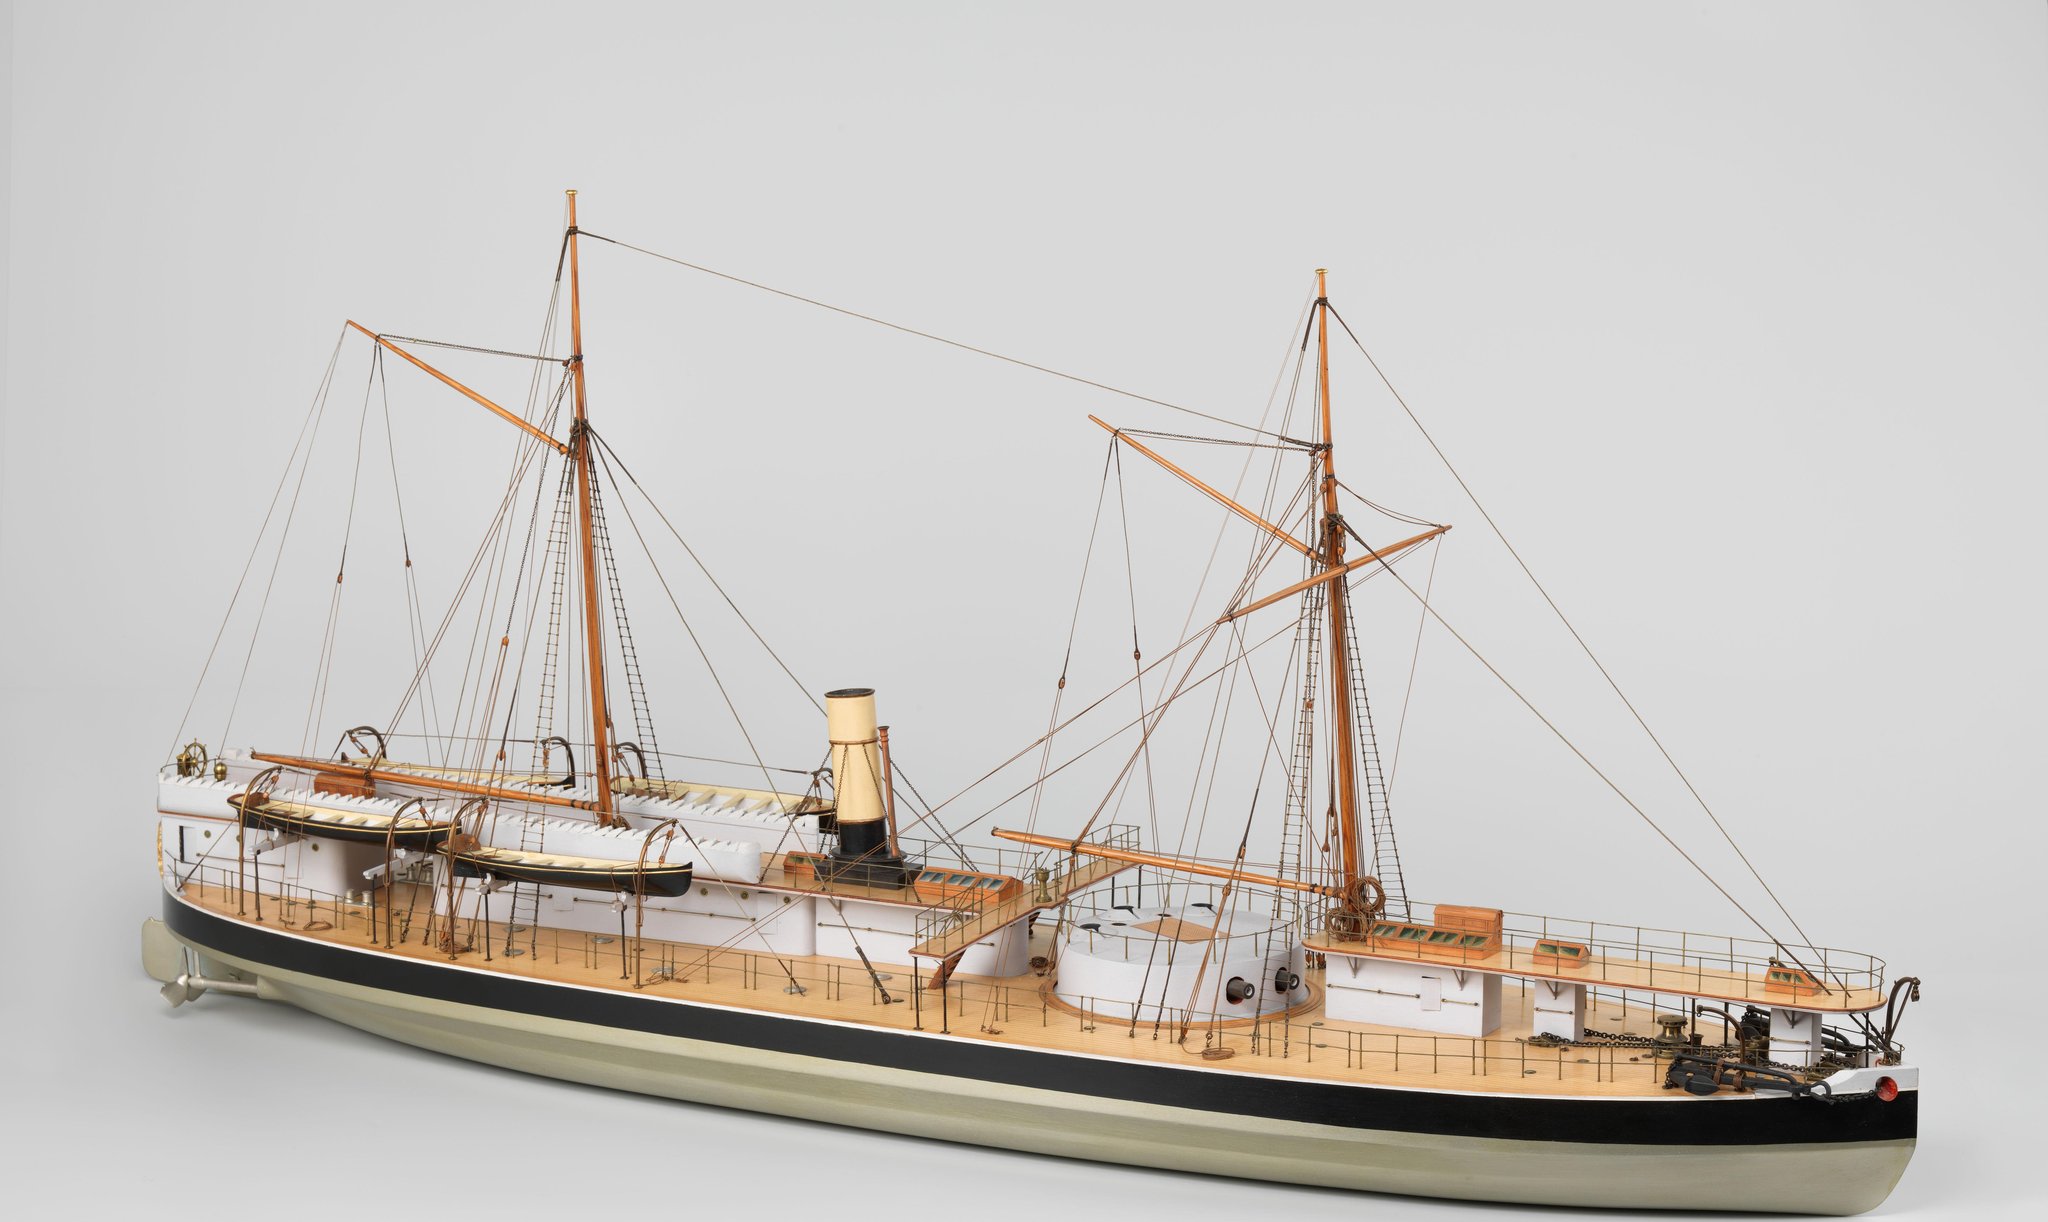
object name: ship model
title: Model of an Ironclad Monitor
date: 1868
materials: brass, paint, fiber, wood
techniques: polychromy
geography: glasgow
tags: tijger (schip)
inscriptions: inscription, on a rectangular brass label: ‘MODEL OF ARMOUR-CLAD TURRET MONITOR "DE TYGER" / SCALE OF 1/4 INCH 1 FOOT / [followed by measurements] / R. NAPIER & SONS. GLASGOW.’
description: The monitor is a product of the American Civil War, named after the first ship of this type. The vessel’s characteristic feature was its low deck on which a large central cannon was installed for a maximum field of fire. The Tijger was built for the Royal Netherlands Navy at the Scottish ship-yard Napier & Sons. Monitors were designed to protect river estuaries and other stretches of inland waterways.